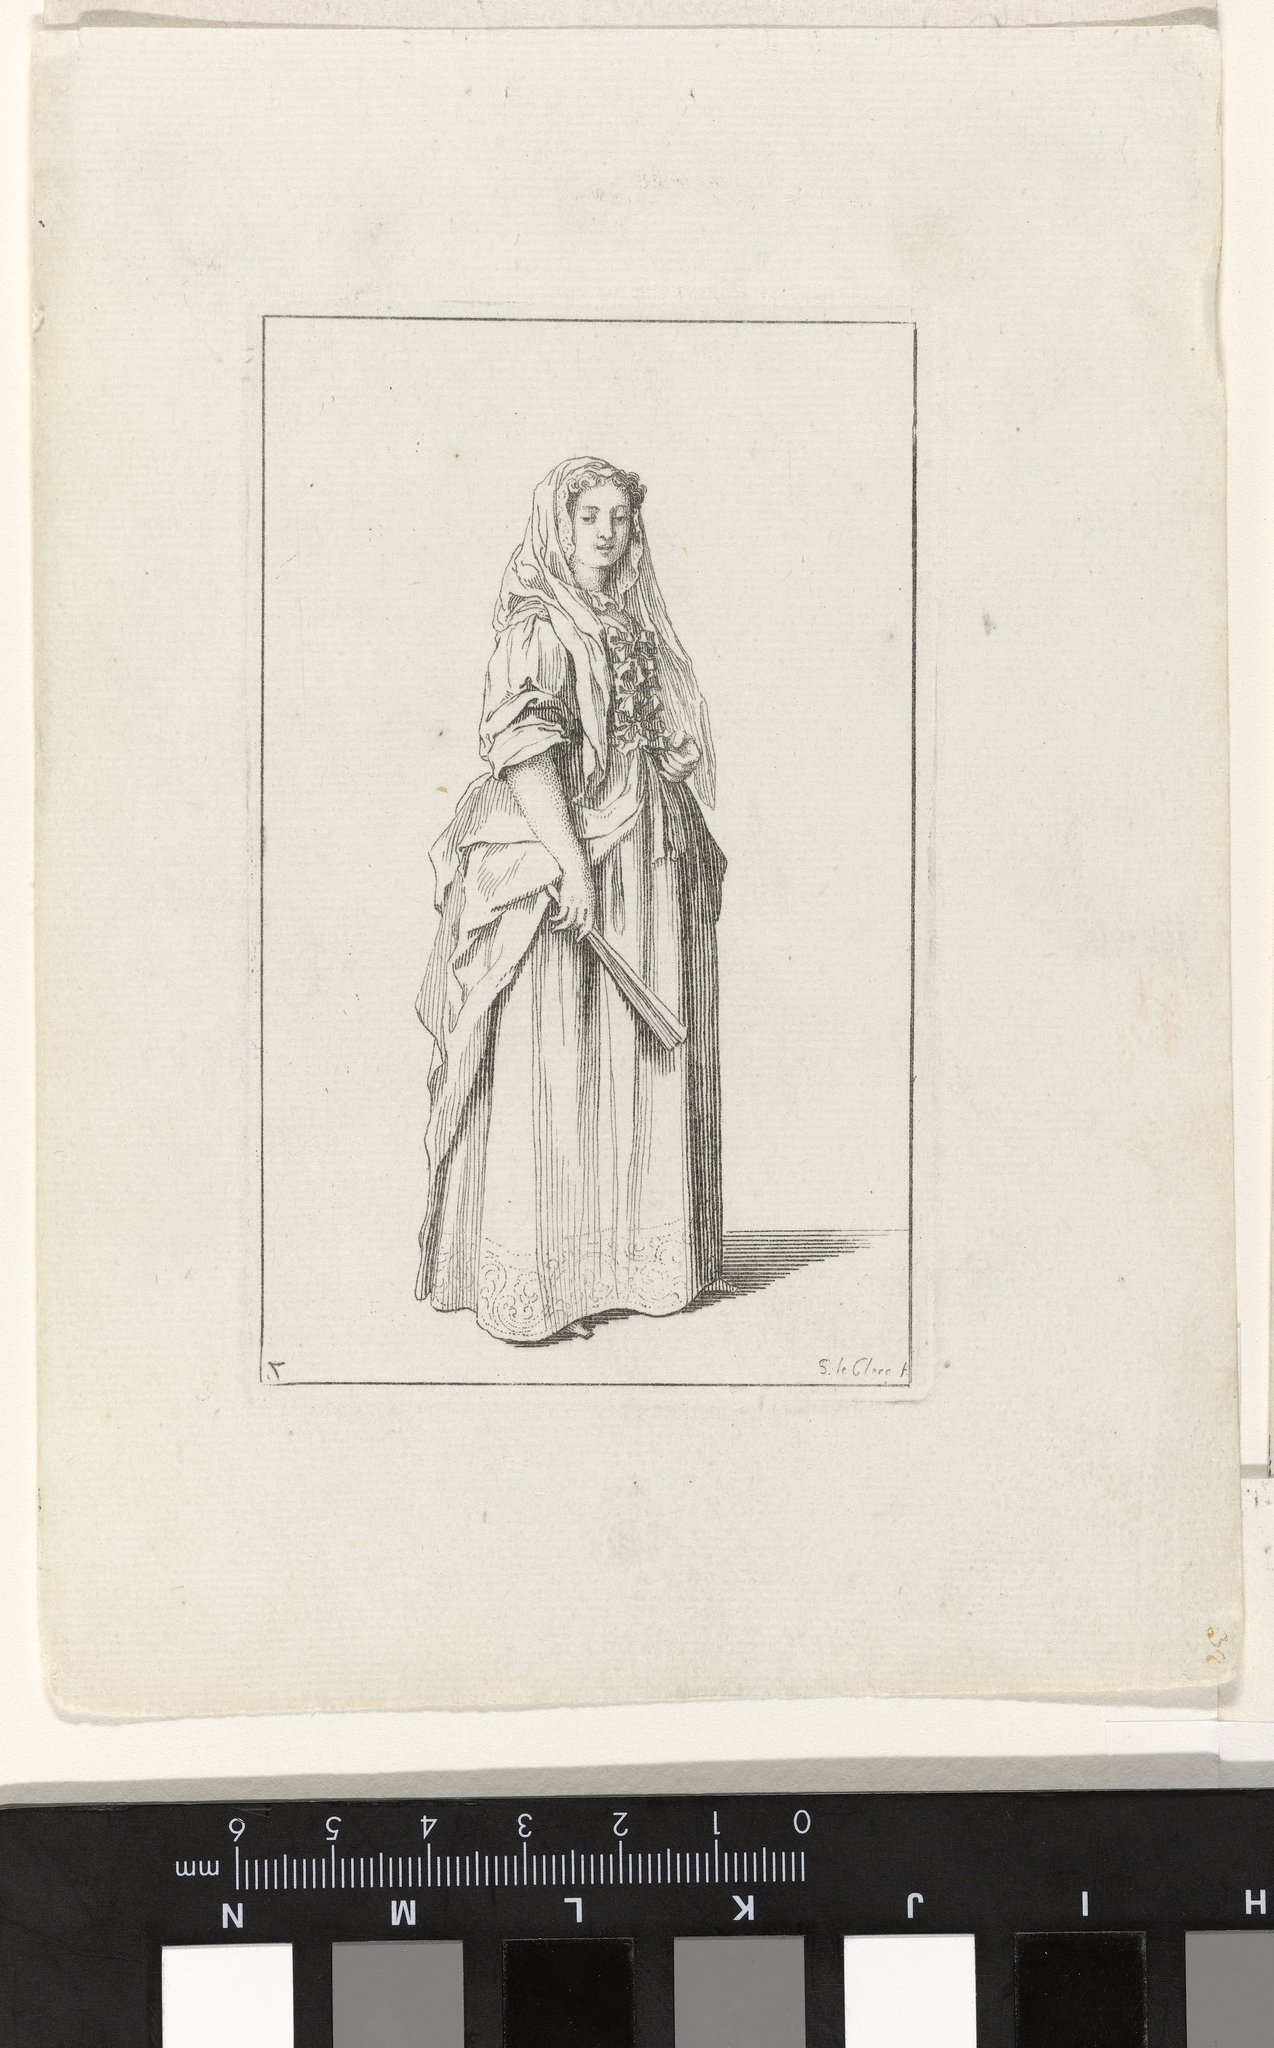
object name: print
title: Dame met sluier en dichtgevouwen waaier, naar rechts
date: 1715-1720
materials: paper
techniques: etching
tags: veil (+ women's clothes), skirt (underskirt) (+ women's clothes), skirt (+ women's clothes), dress, gown (+ women's clothes), dress, gown: manteau (+ women's clothes), sleeves (+ women's clothes), clothing for the upper part of the body (with name) (+ women's clothes)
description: Jonge vrouw, driekwart naar rechts, een kanten sluier over het hoofd, gesloten vouwwaaier in de rechterhand. Lijfje met mouwen tot aan de elleboog. Van het overkleed is de rok opgenomen zodat de onderrok zichtbaar is. No. 5 uit de serie Figures a la mode dédiees a M. le Duc de Bourgogne